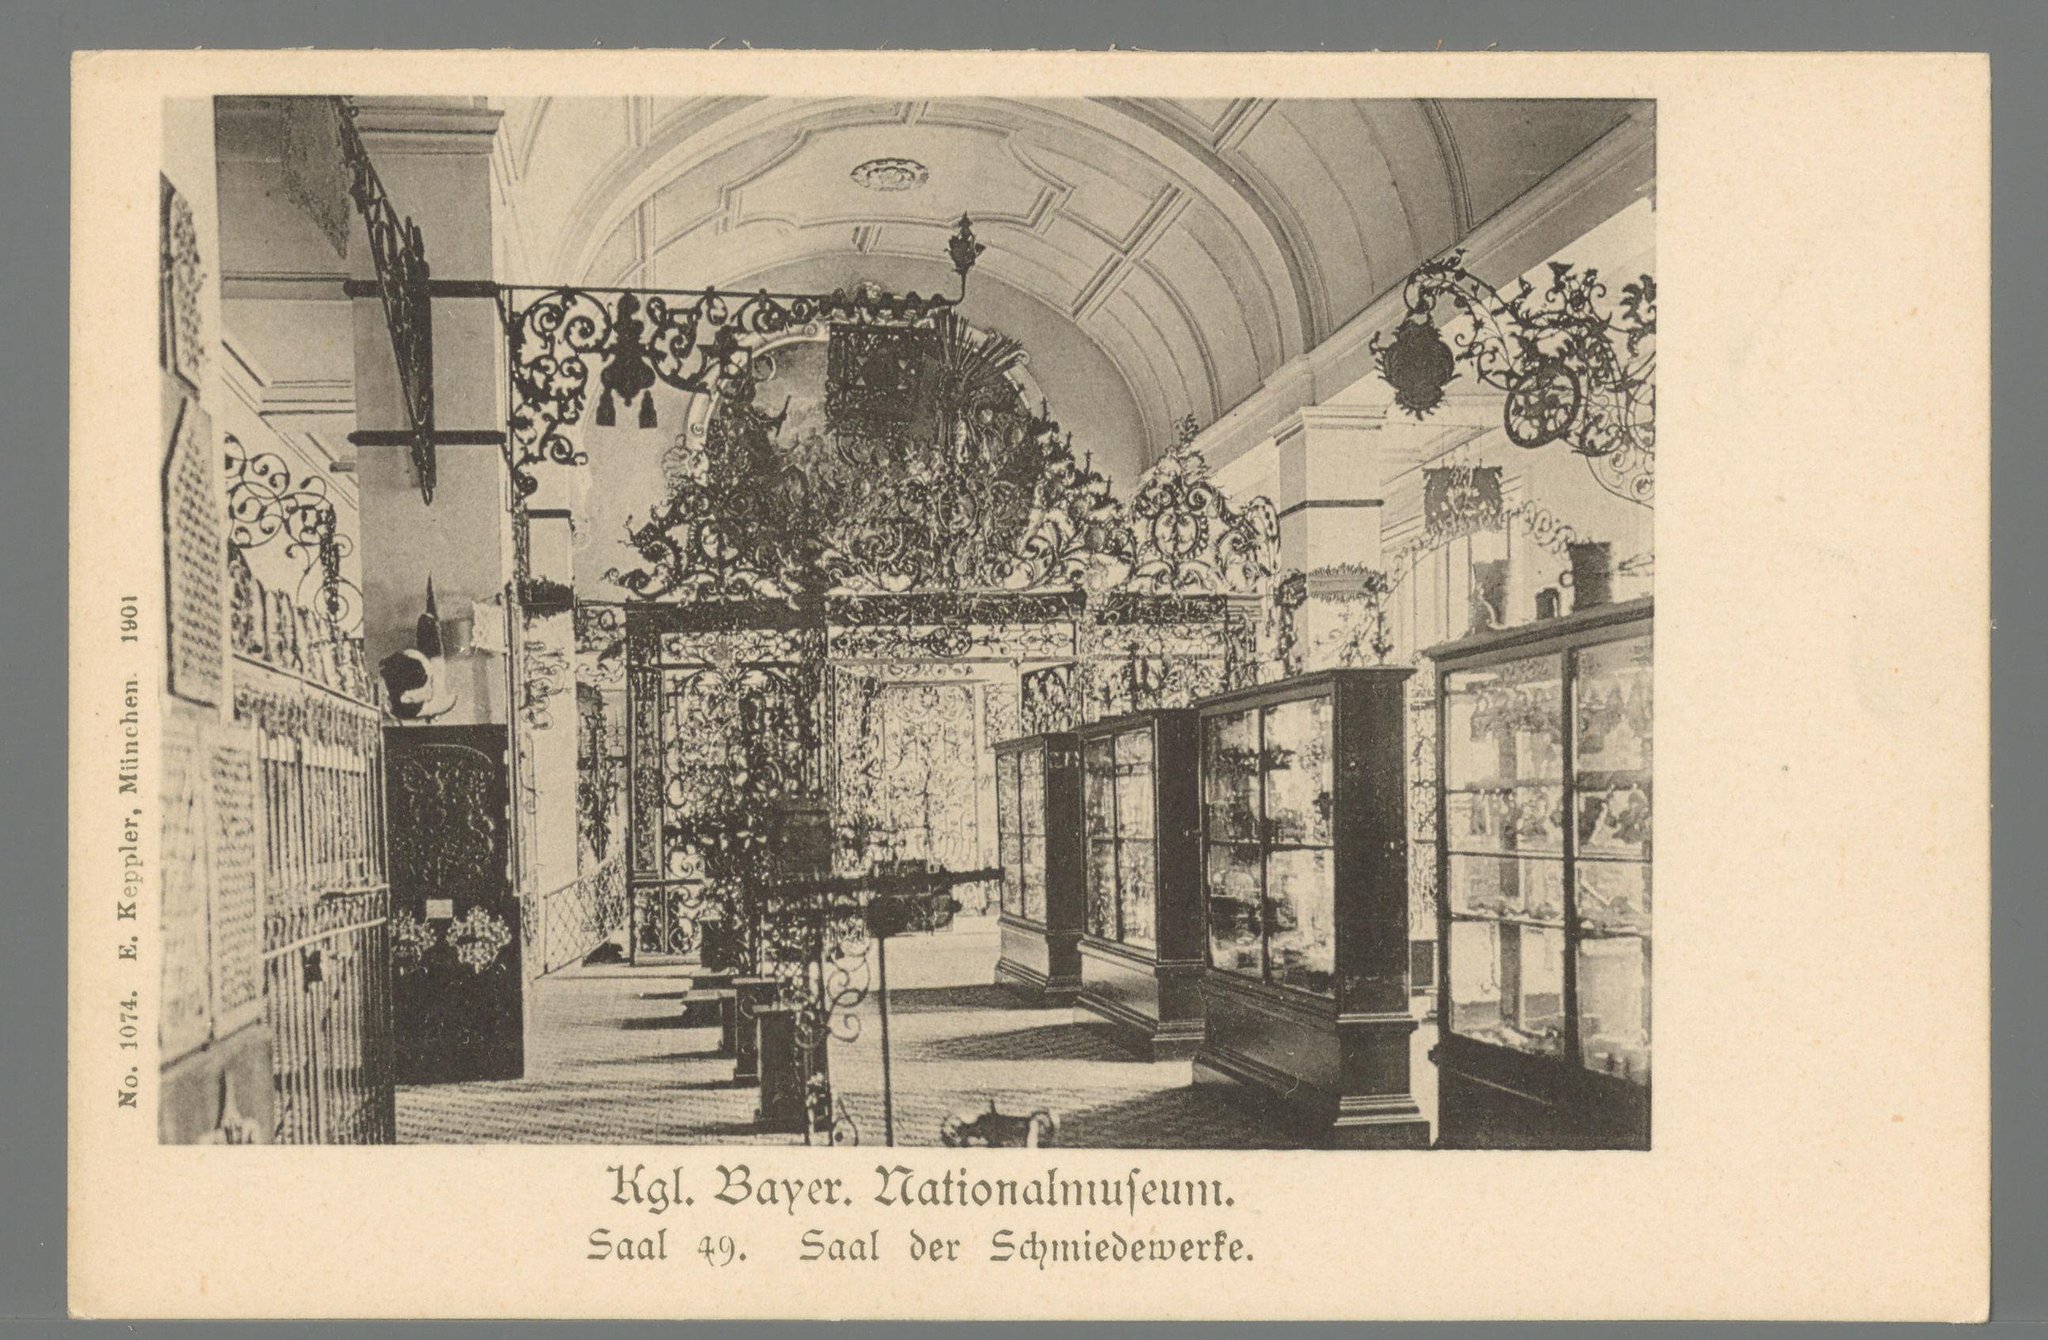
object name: photomechanical print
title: Kgl. Bayer. Nationalmuseum. Saal 49. Saal der Schmiedewerke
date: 1901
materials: cardboard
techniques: photograph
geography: munich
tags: permanent exhibition, museum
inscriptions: date